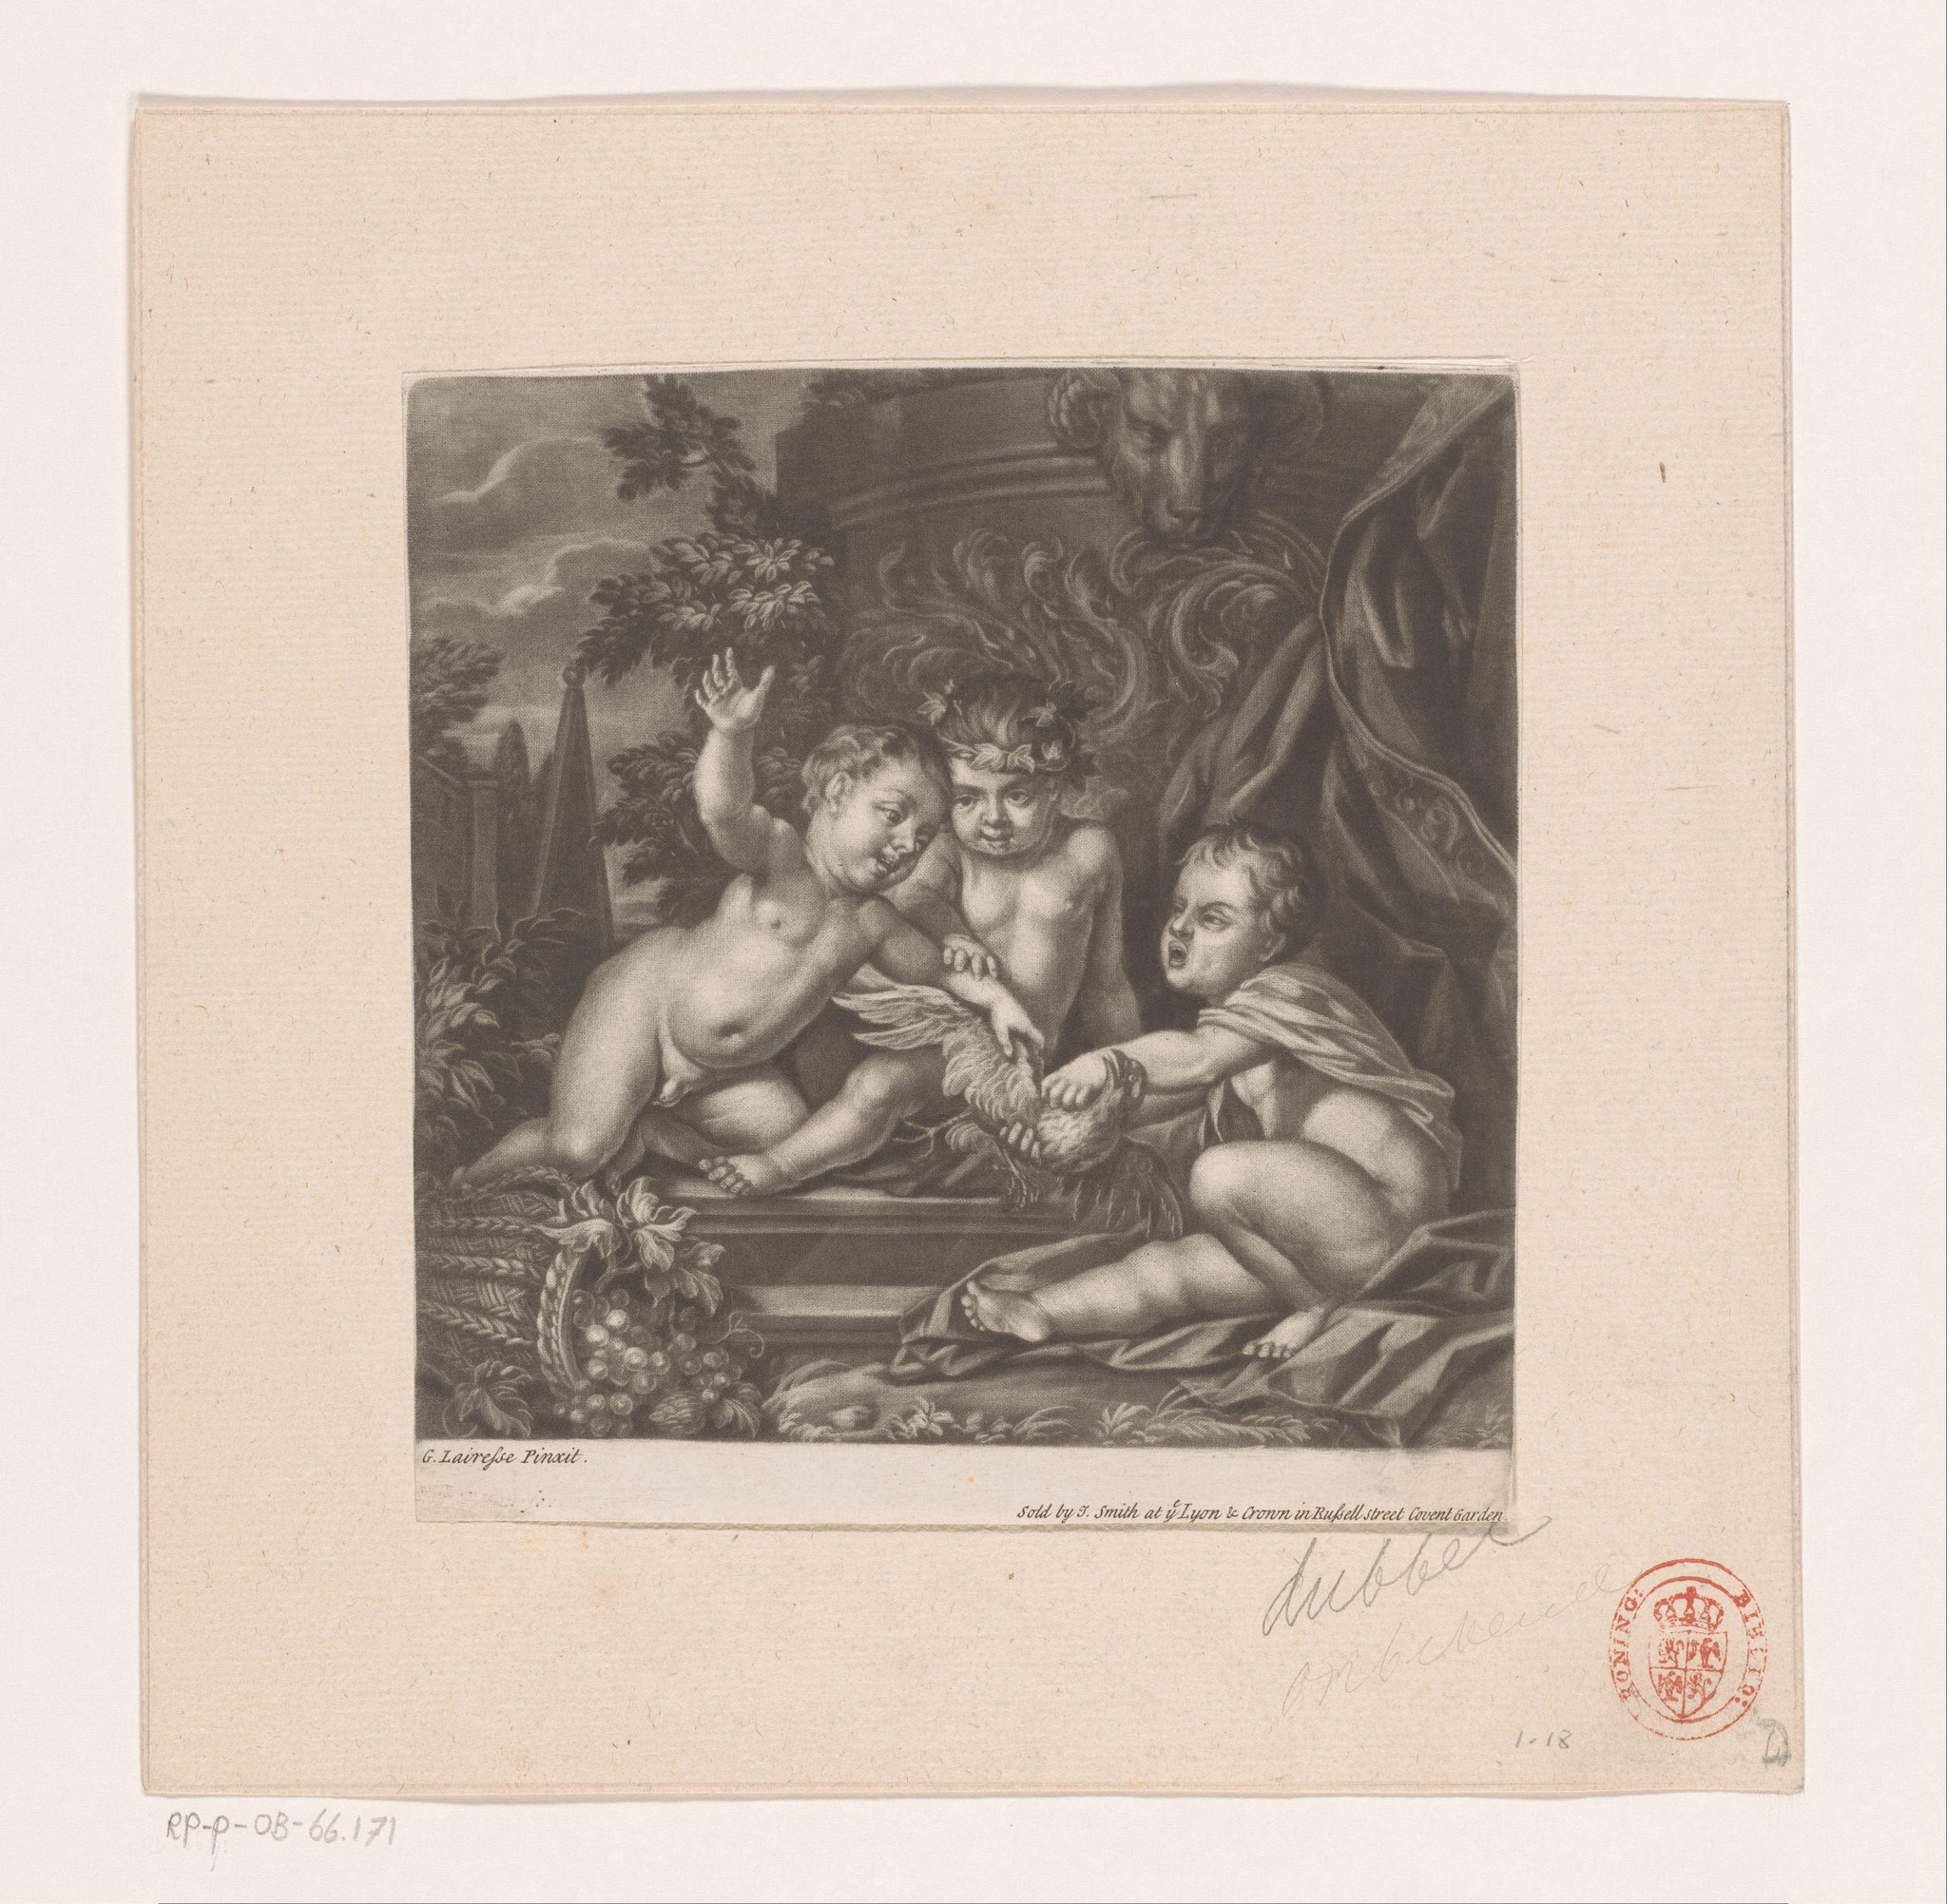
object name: print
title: Drie cupido's met een vogel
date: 1662-1742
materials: paper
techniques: mezzotint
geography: london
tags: cupids: 'amores', 'amoretti', 'putti', child teasing animals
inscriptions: collector's mark: Lugt 240